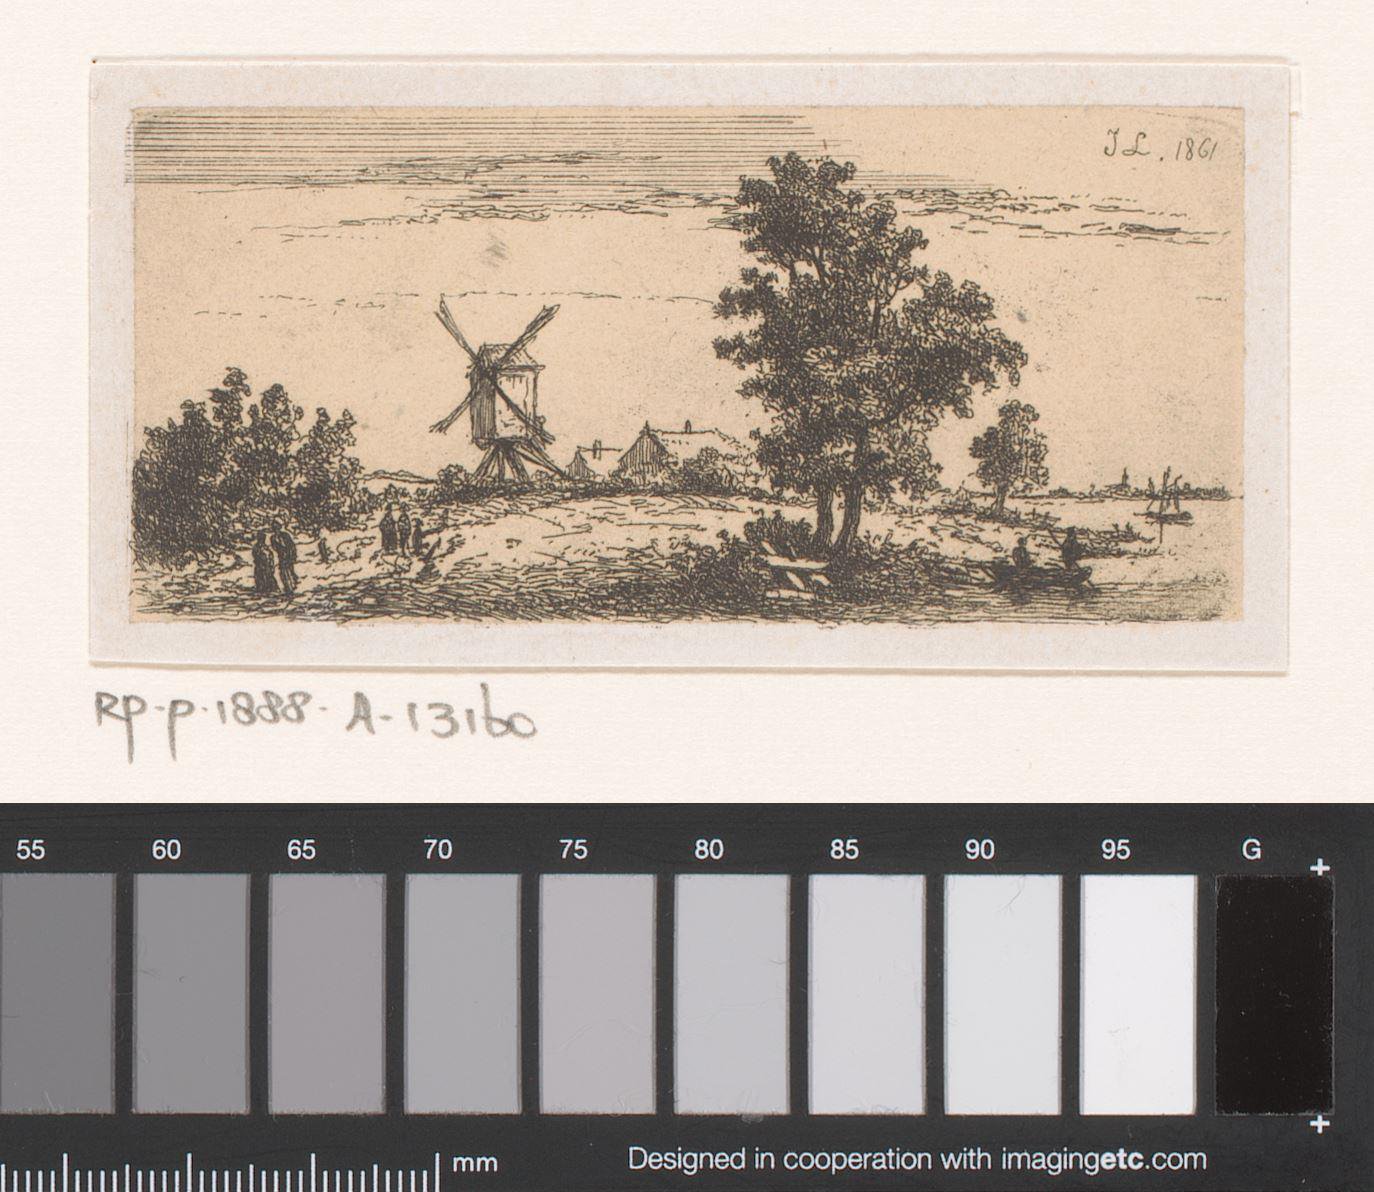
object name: print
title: Landschap bij de Merwede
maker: jean théodore joseph linnig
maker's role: draughtsman, print maker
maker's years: 1815-1891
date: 1861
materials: paper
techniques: etching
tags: river, windmill in landscape, windmill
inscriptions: collector's mark: Lugt 2228